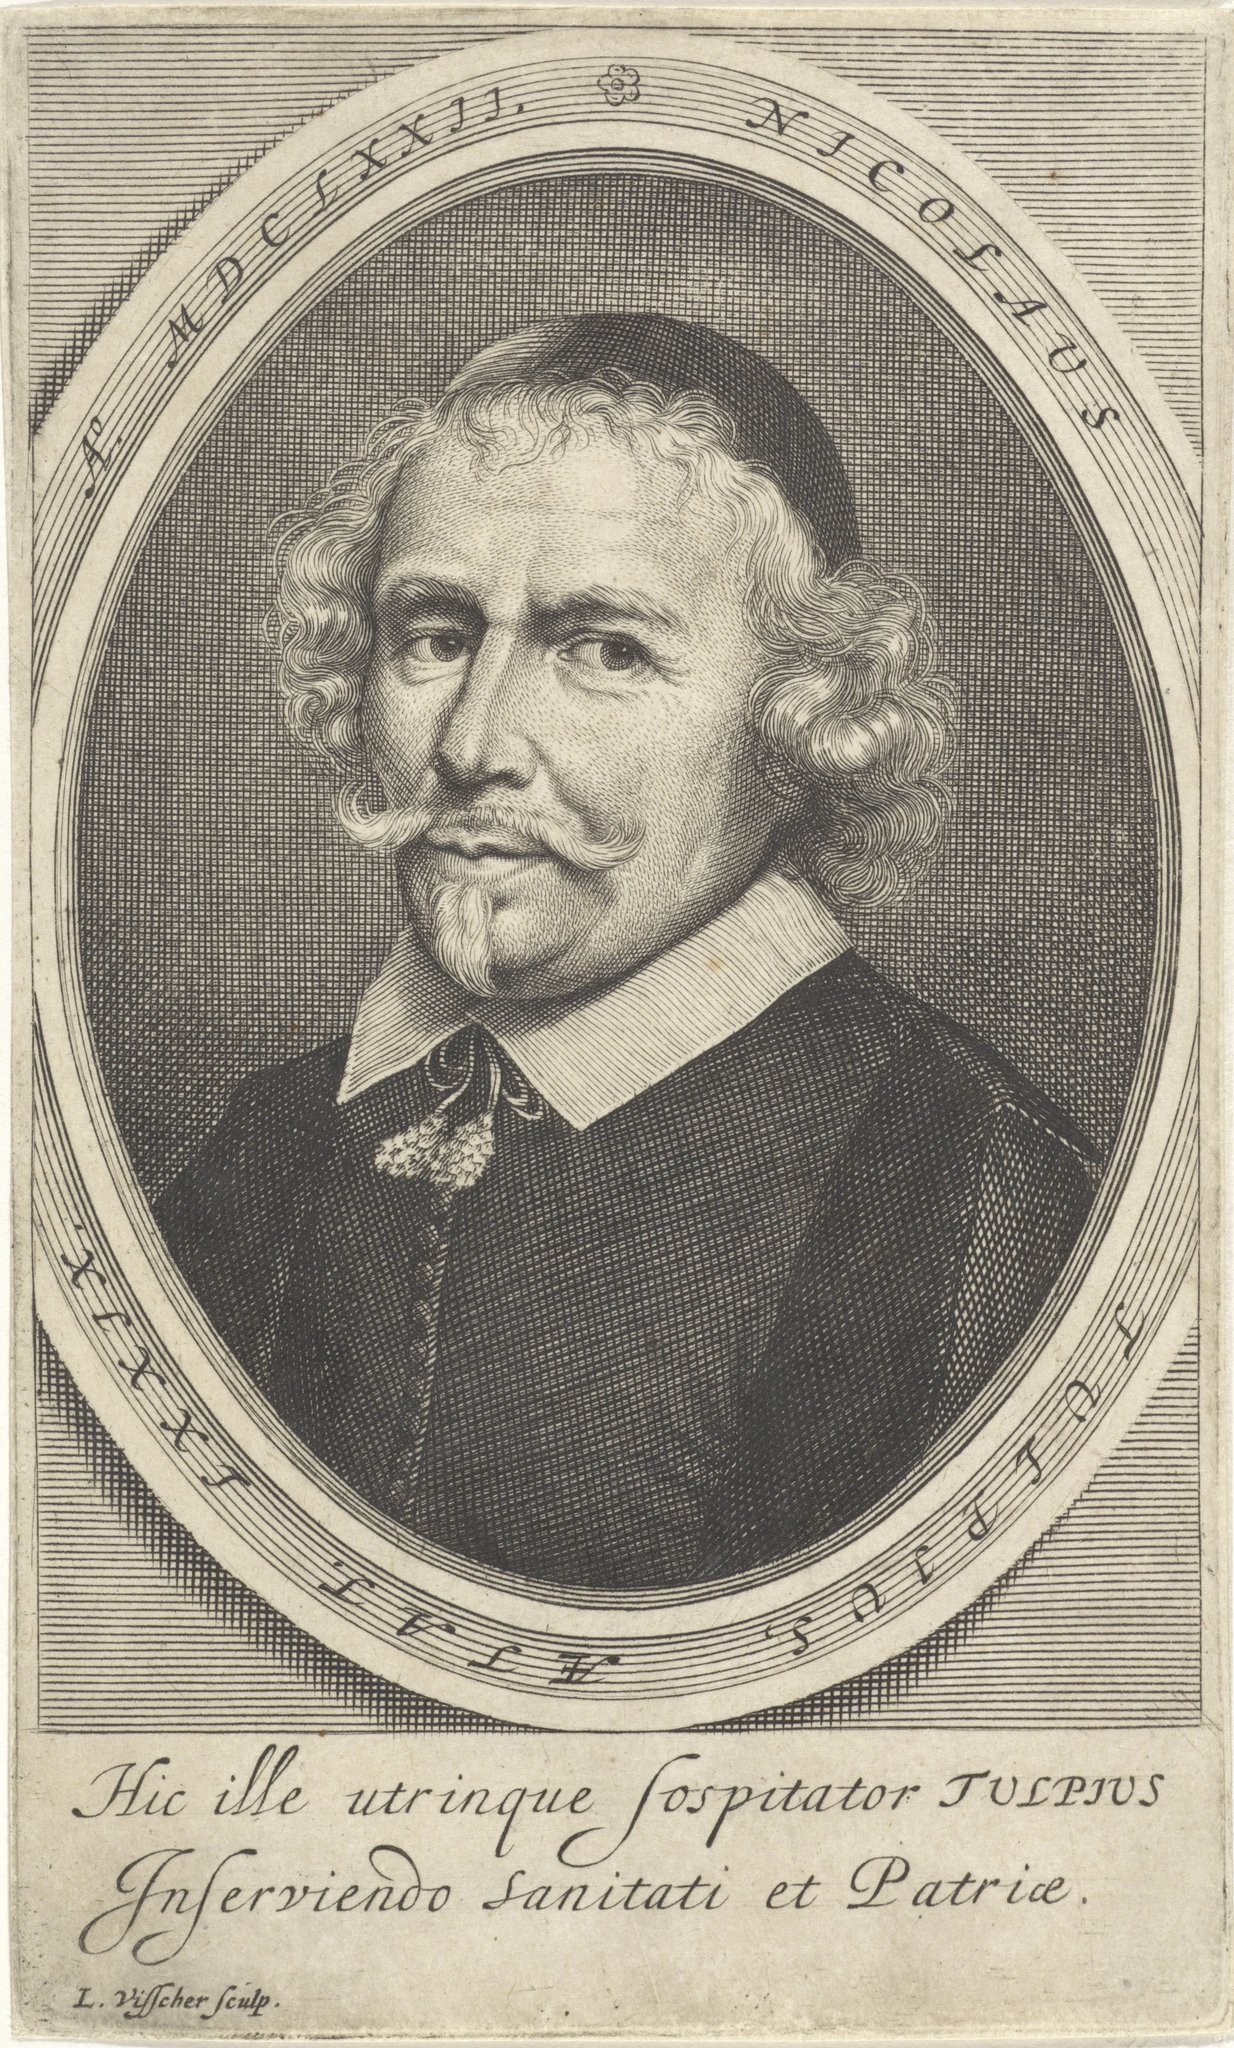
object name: print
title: Portret van de geneesheer Nicolaas Tulp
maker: lambert visscher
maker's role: draughtsman, print maker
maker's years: 1640-1679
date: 1643-1691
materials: paper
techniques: engraving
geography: northern netherlands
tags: mayor, historical persons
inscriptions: collector's mark: Lugt 240